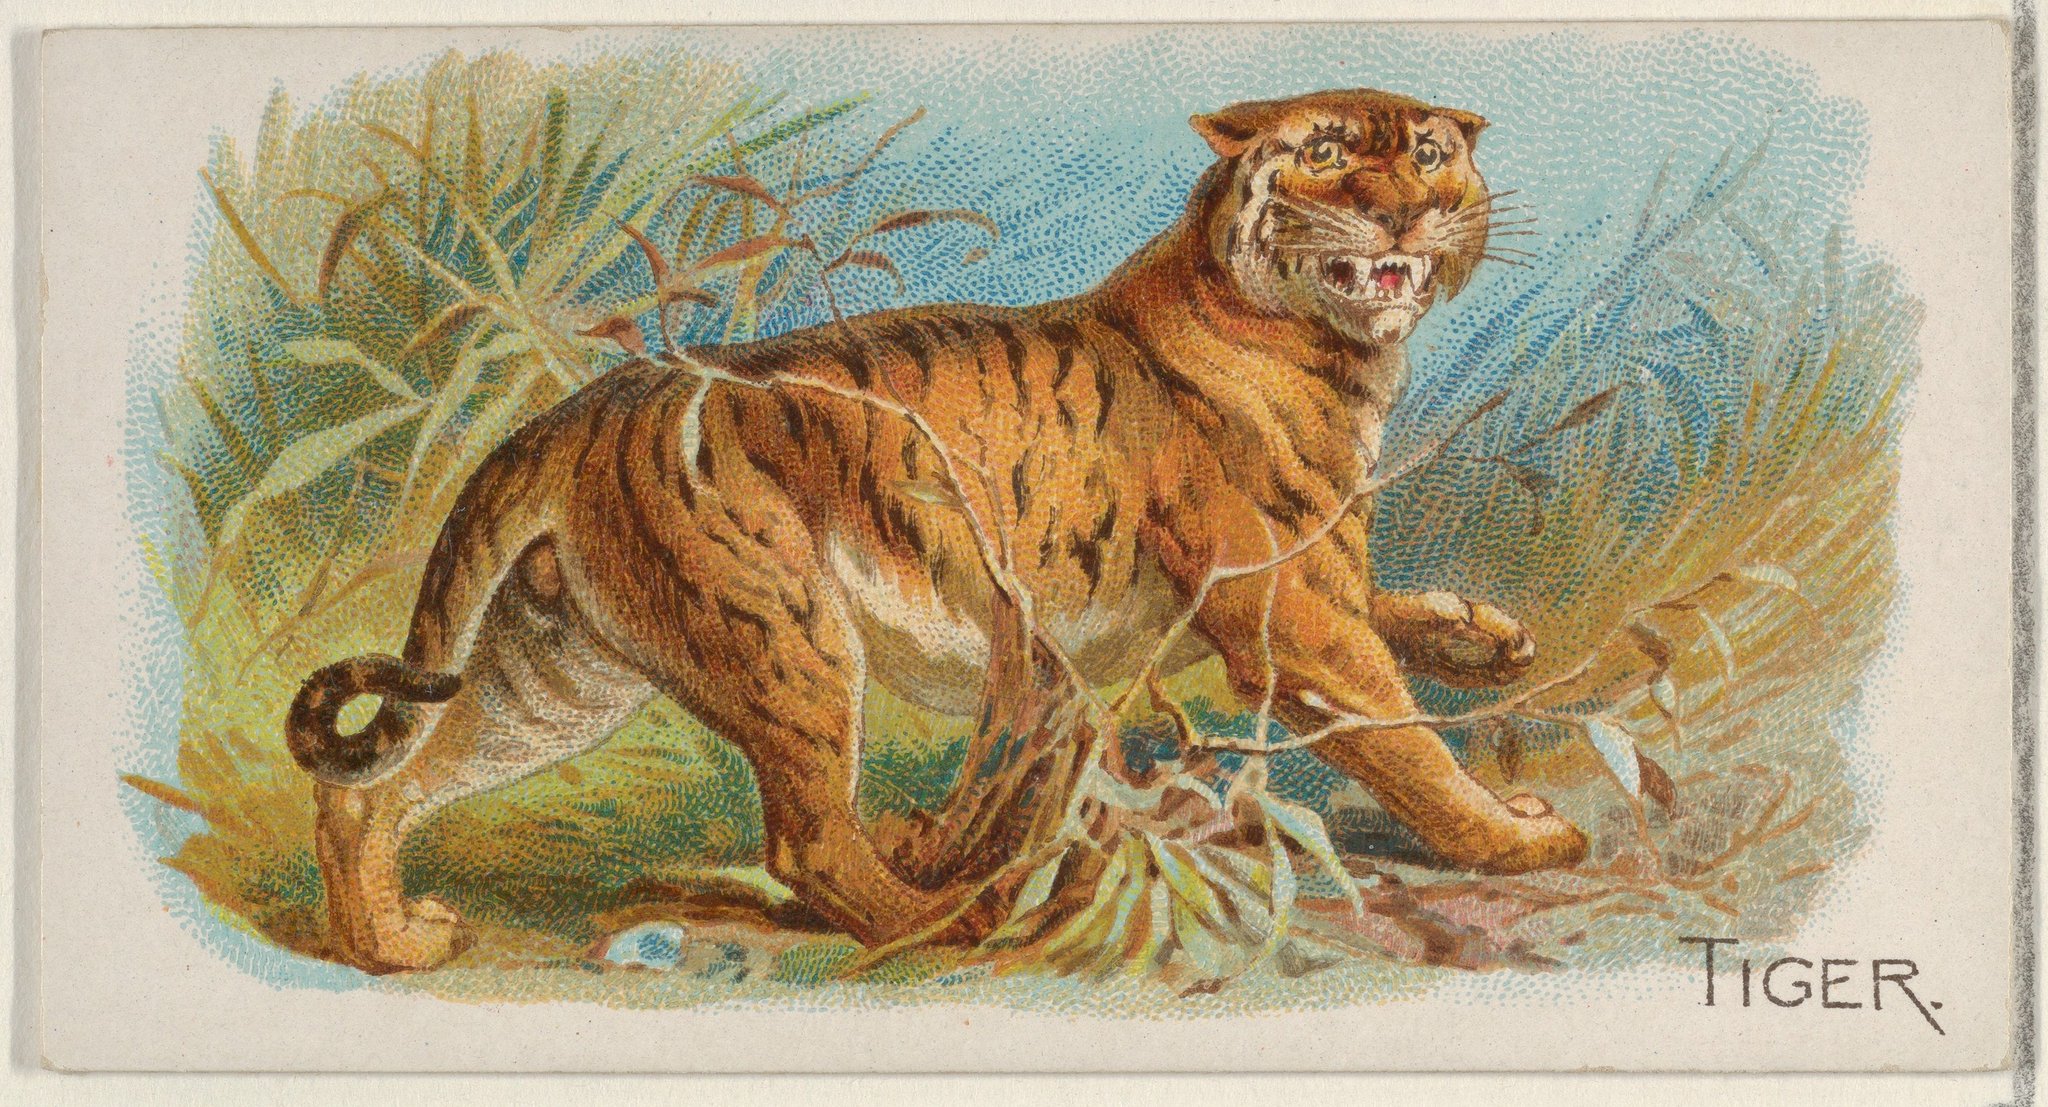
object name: print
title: Tiger, from the Quadrupeds series (N21) for Allen & Ginter Cigarettes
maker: allen & ginter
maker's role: publisher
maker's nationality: american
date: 1890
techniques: color lithograph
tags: tigers